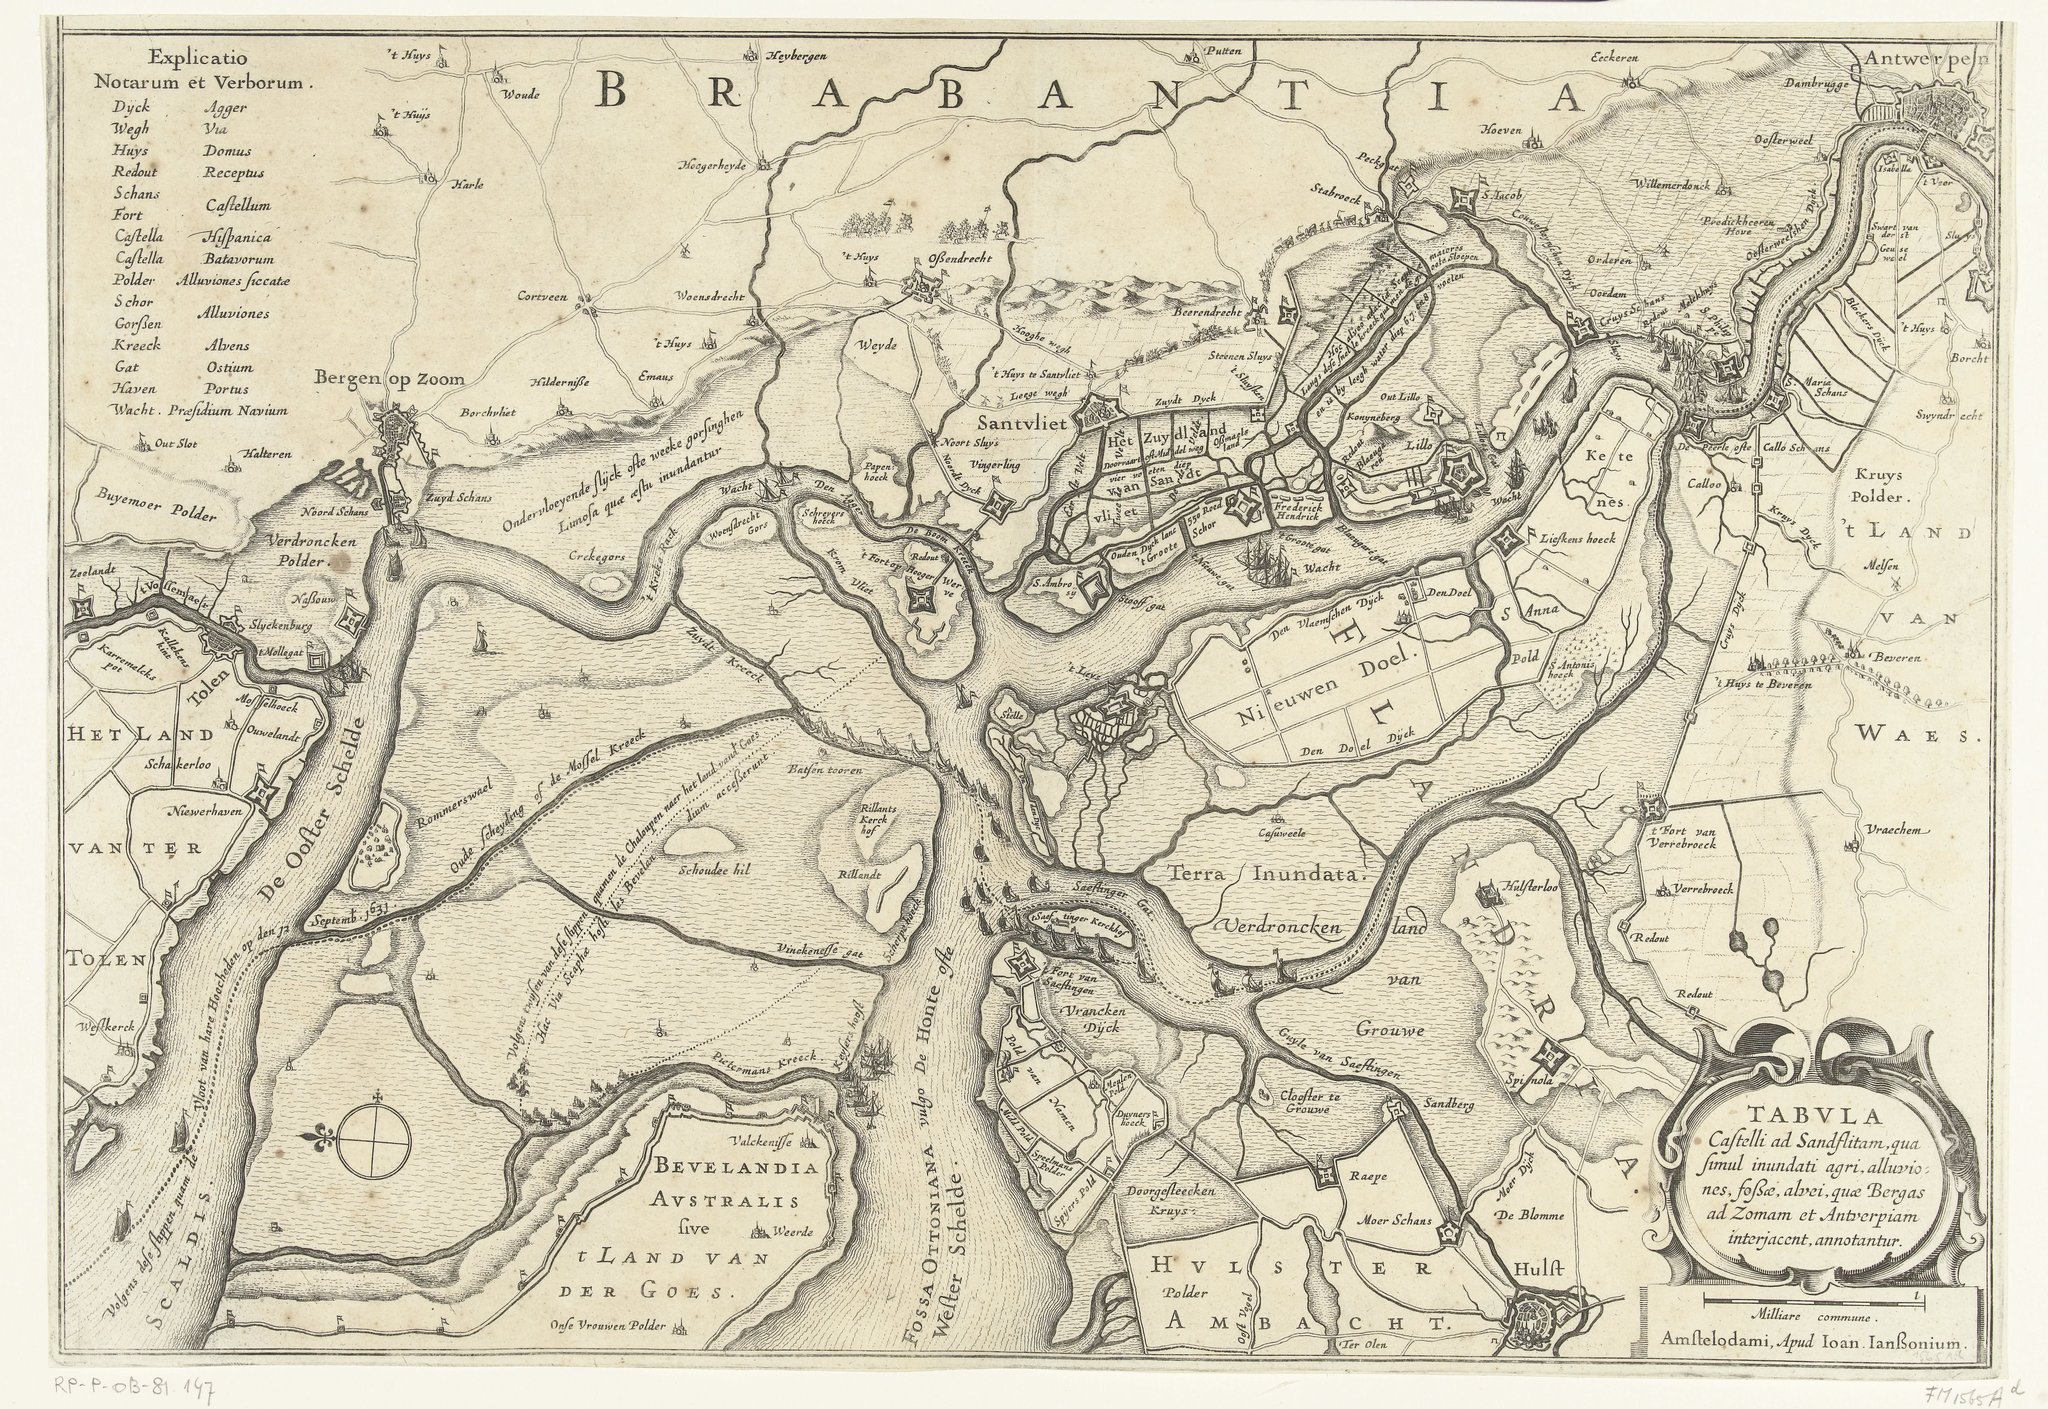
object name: map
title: Forten aan de Ooster- en Westerschelde, 1627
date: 1629-1665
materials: paper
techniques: etching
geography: northern netherlands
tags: maps of separate countries or regions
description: Kaart van forten aan de Ooster- en Westerschelde en rond Zandvliet, 1627. Wellicht in relatie met de aanslag door Spinola op Zuid-Beveland, september 1627. Linksboven de vertaling van termen Nederlands - Latijn. Rechtsonder een cartouche met de titel.